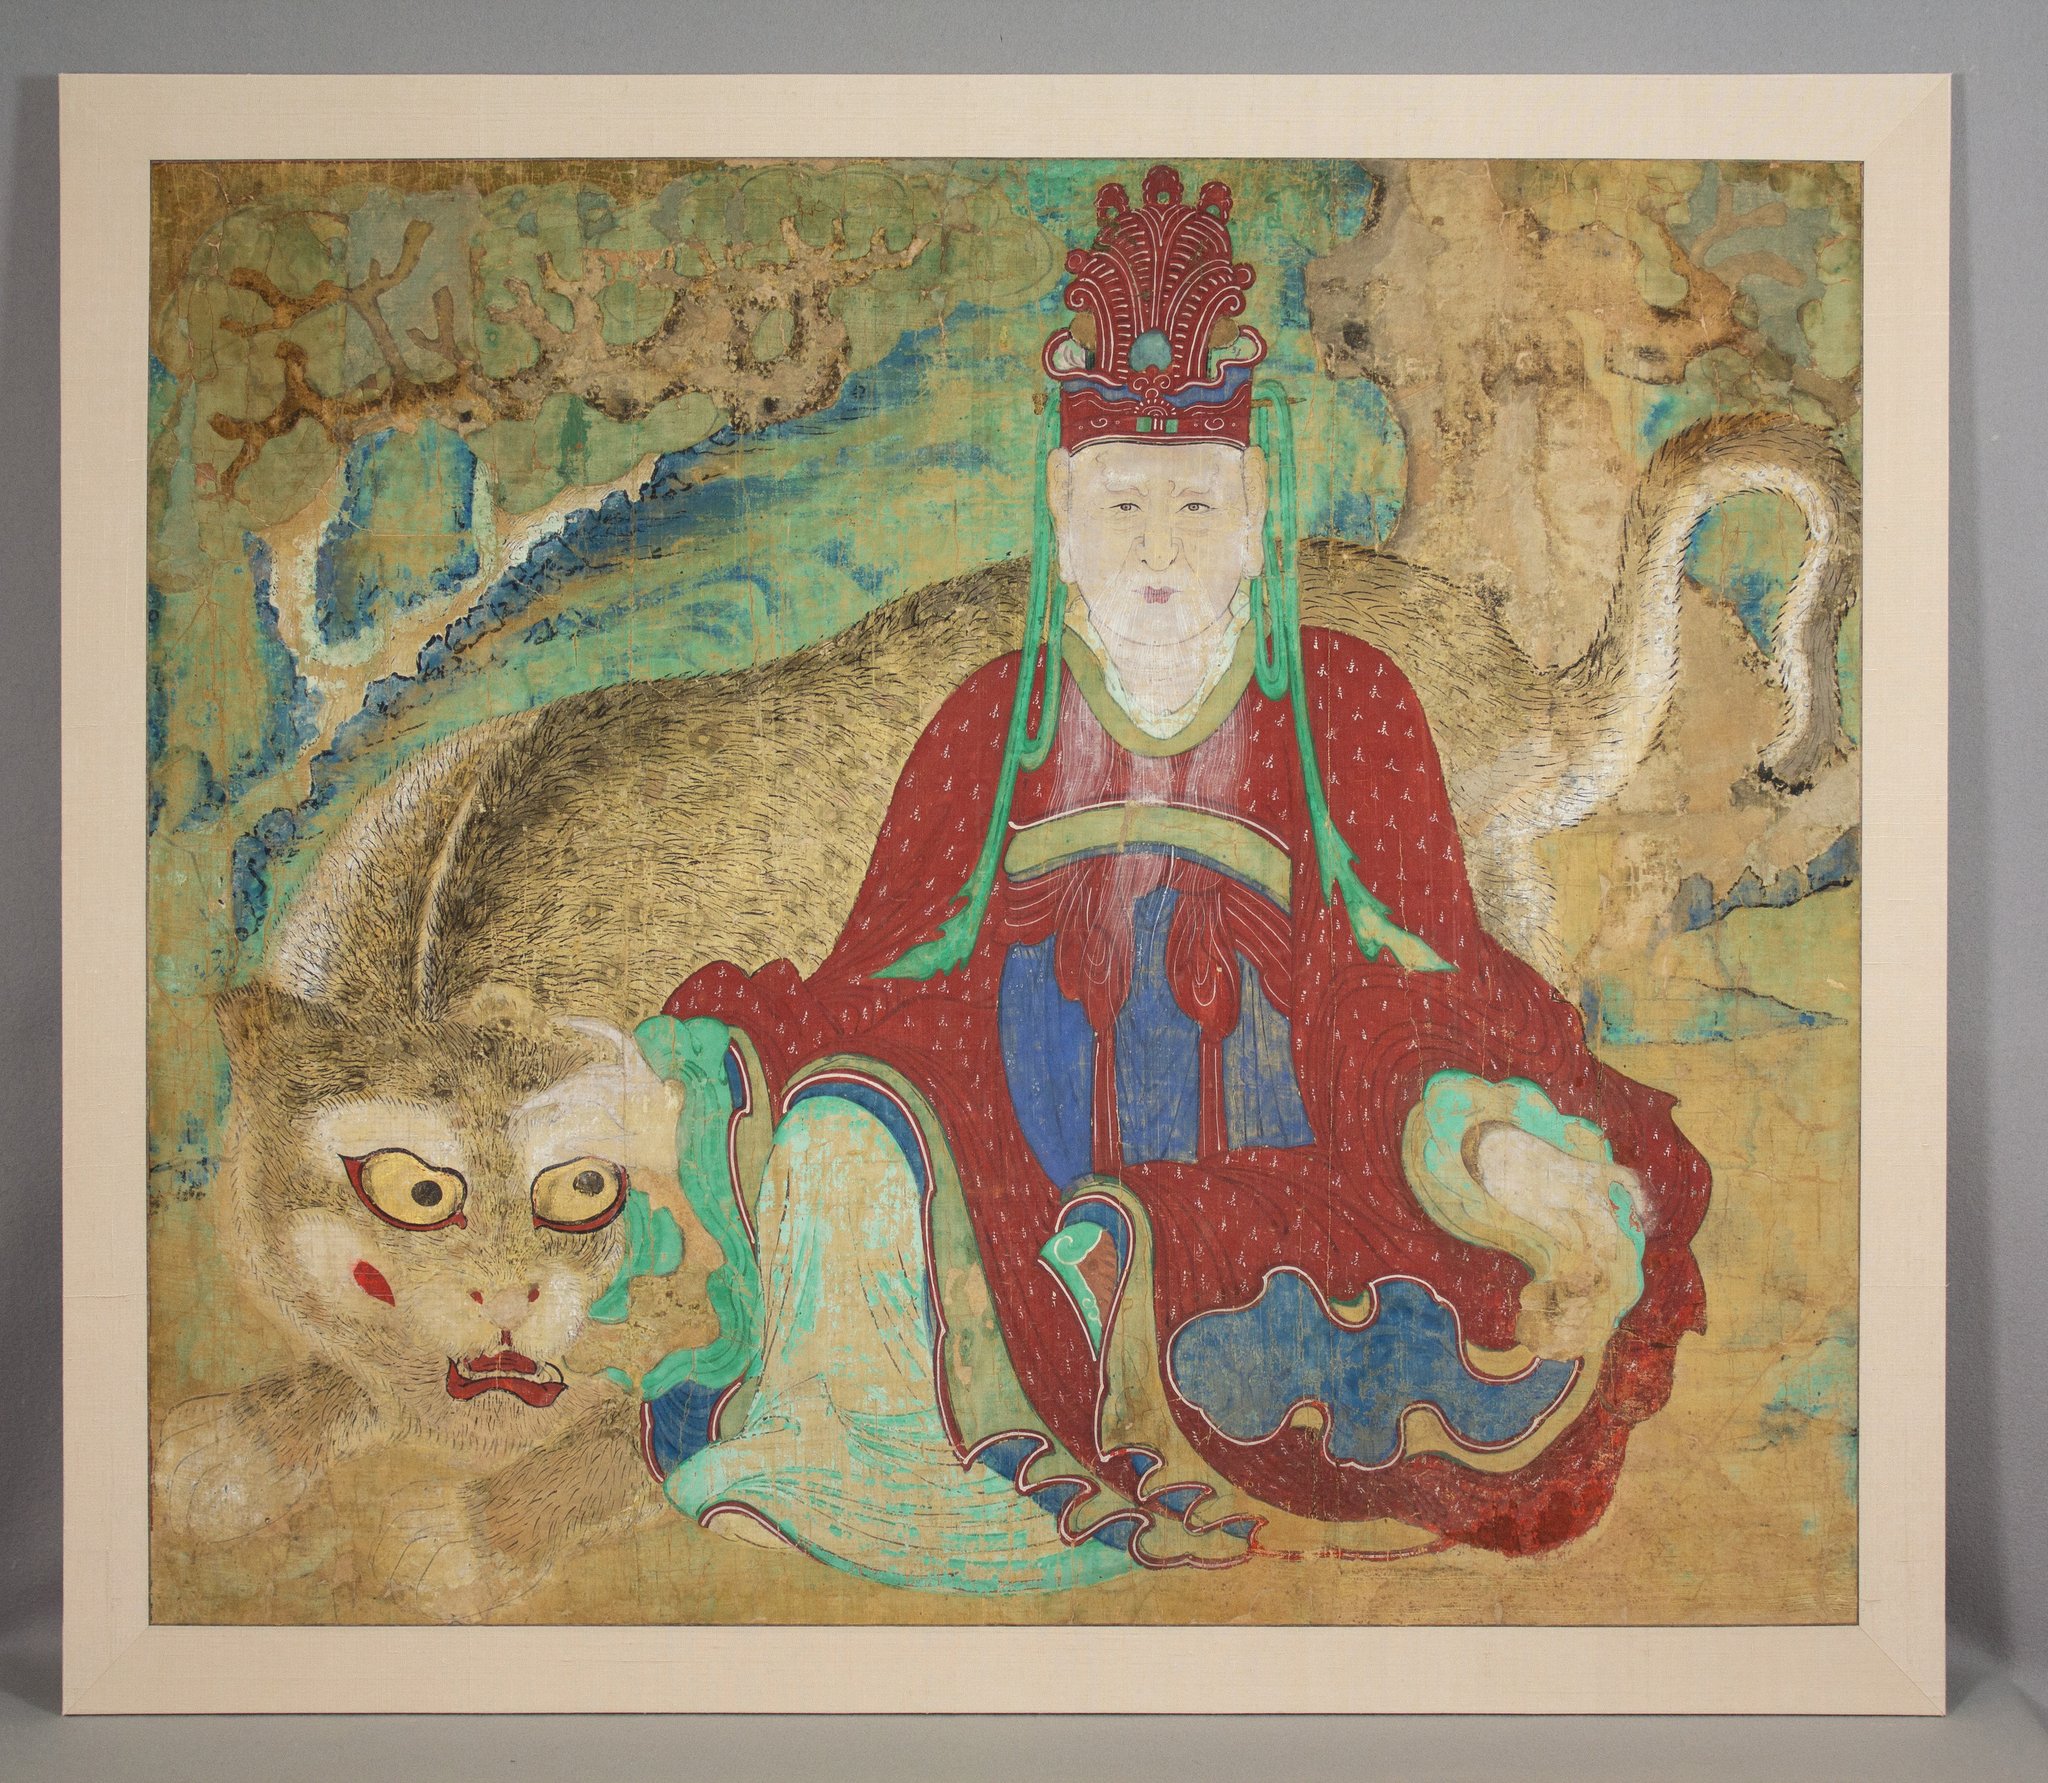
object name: painting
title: Mountain god with tiger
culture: korean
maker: unidentified artist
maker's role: artist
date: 1867-1900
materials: ink, silk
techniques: painting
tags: tigers